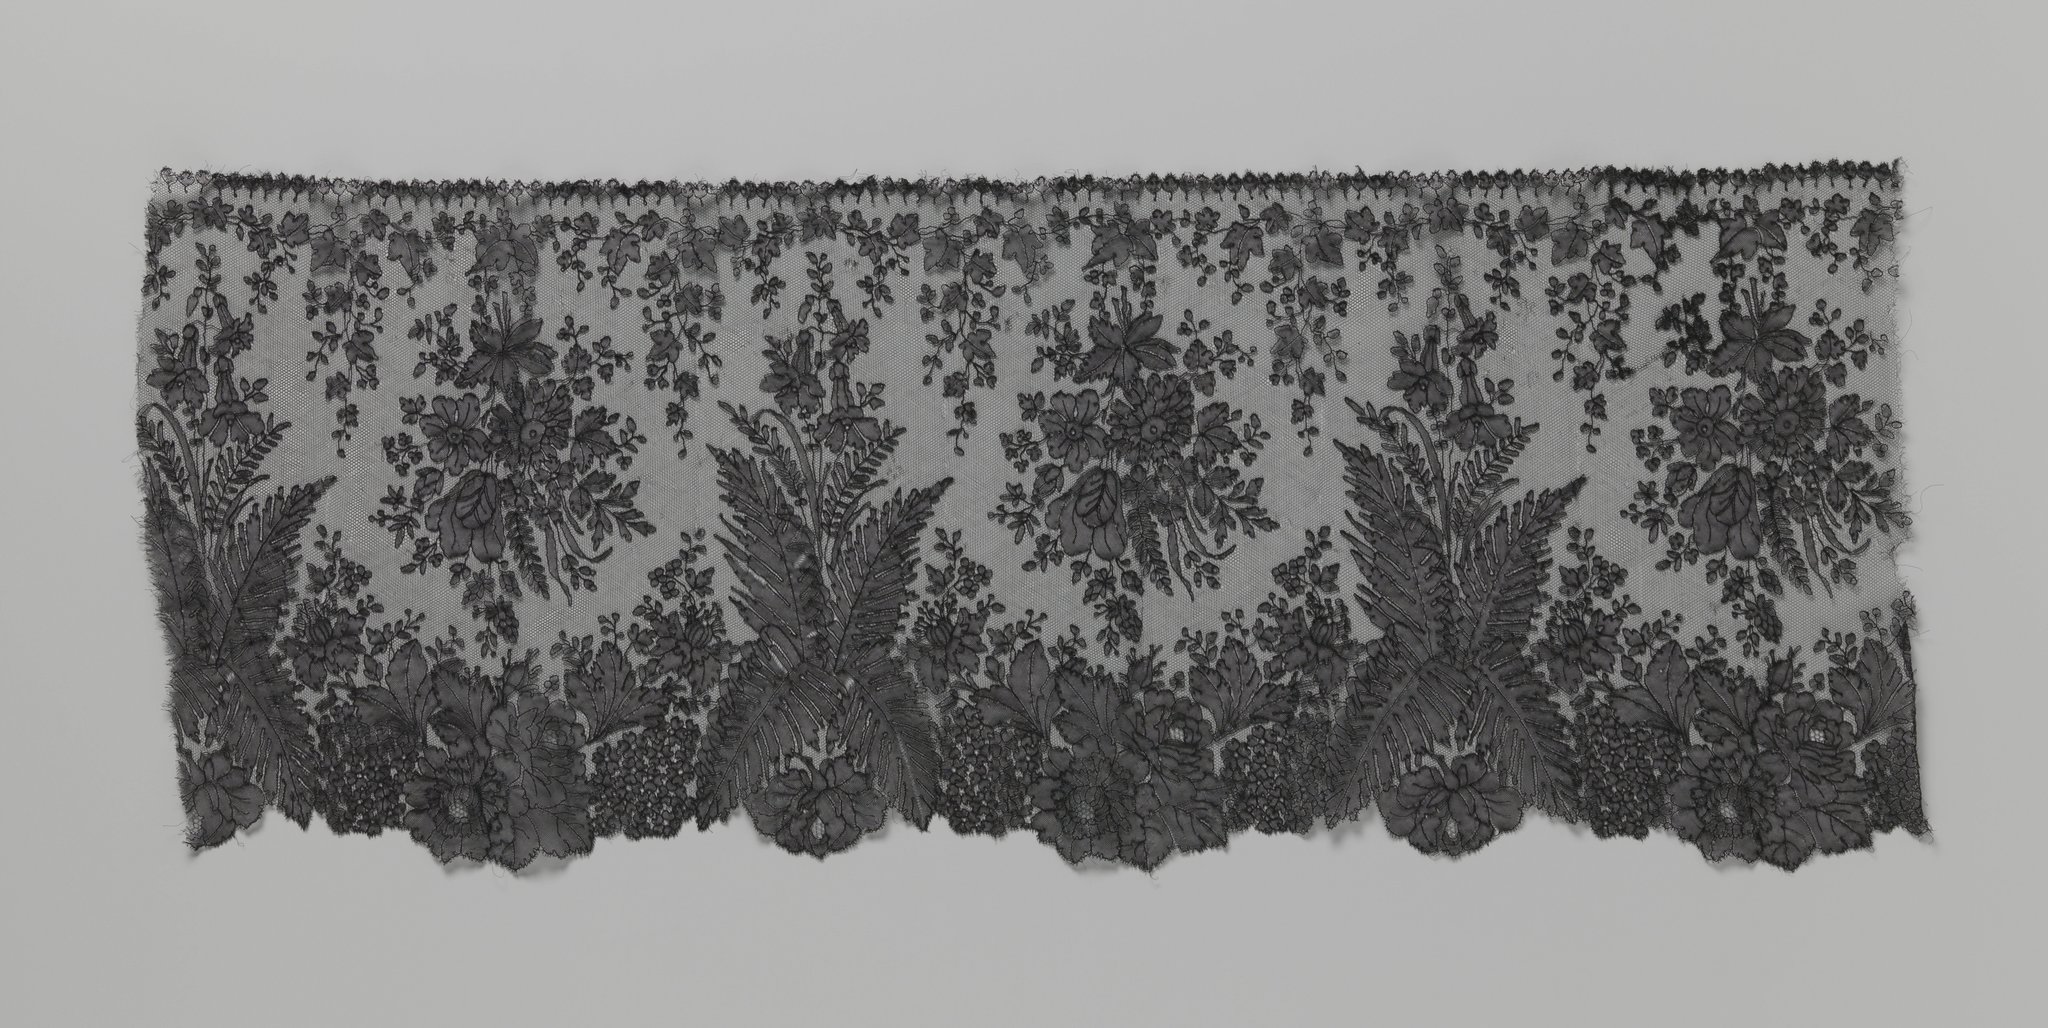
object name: strip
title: Japonstrook van kloskant met varens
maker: Anonymous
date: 1850-1855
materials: silk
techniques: lace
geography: france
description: Japonstrook van zwarte kloskant: Chantilly-kant. Op een leeg mazenfond staat een gesloten rand met schulpen, gevuld met een guirlande van bloemen en bladeren. Op de snijpunten staat een kleine schulp met een hangende roos, waarboven een spits boeket oprijst van vier grote varenbladeren en een bloemtak, die tot aan de bovenrand reikt. Hier loopt een horizontale klimoprank met hangende takjes, terwijl op het veld boven de grote schulp van deze klimoprank een groot boeket afhangt, onder andere met een tulp.